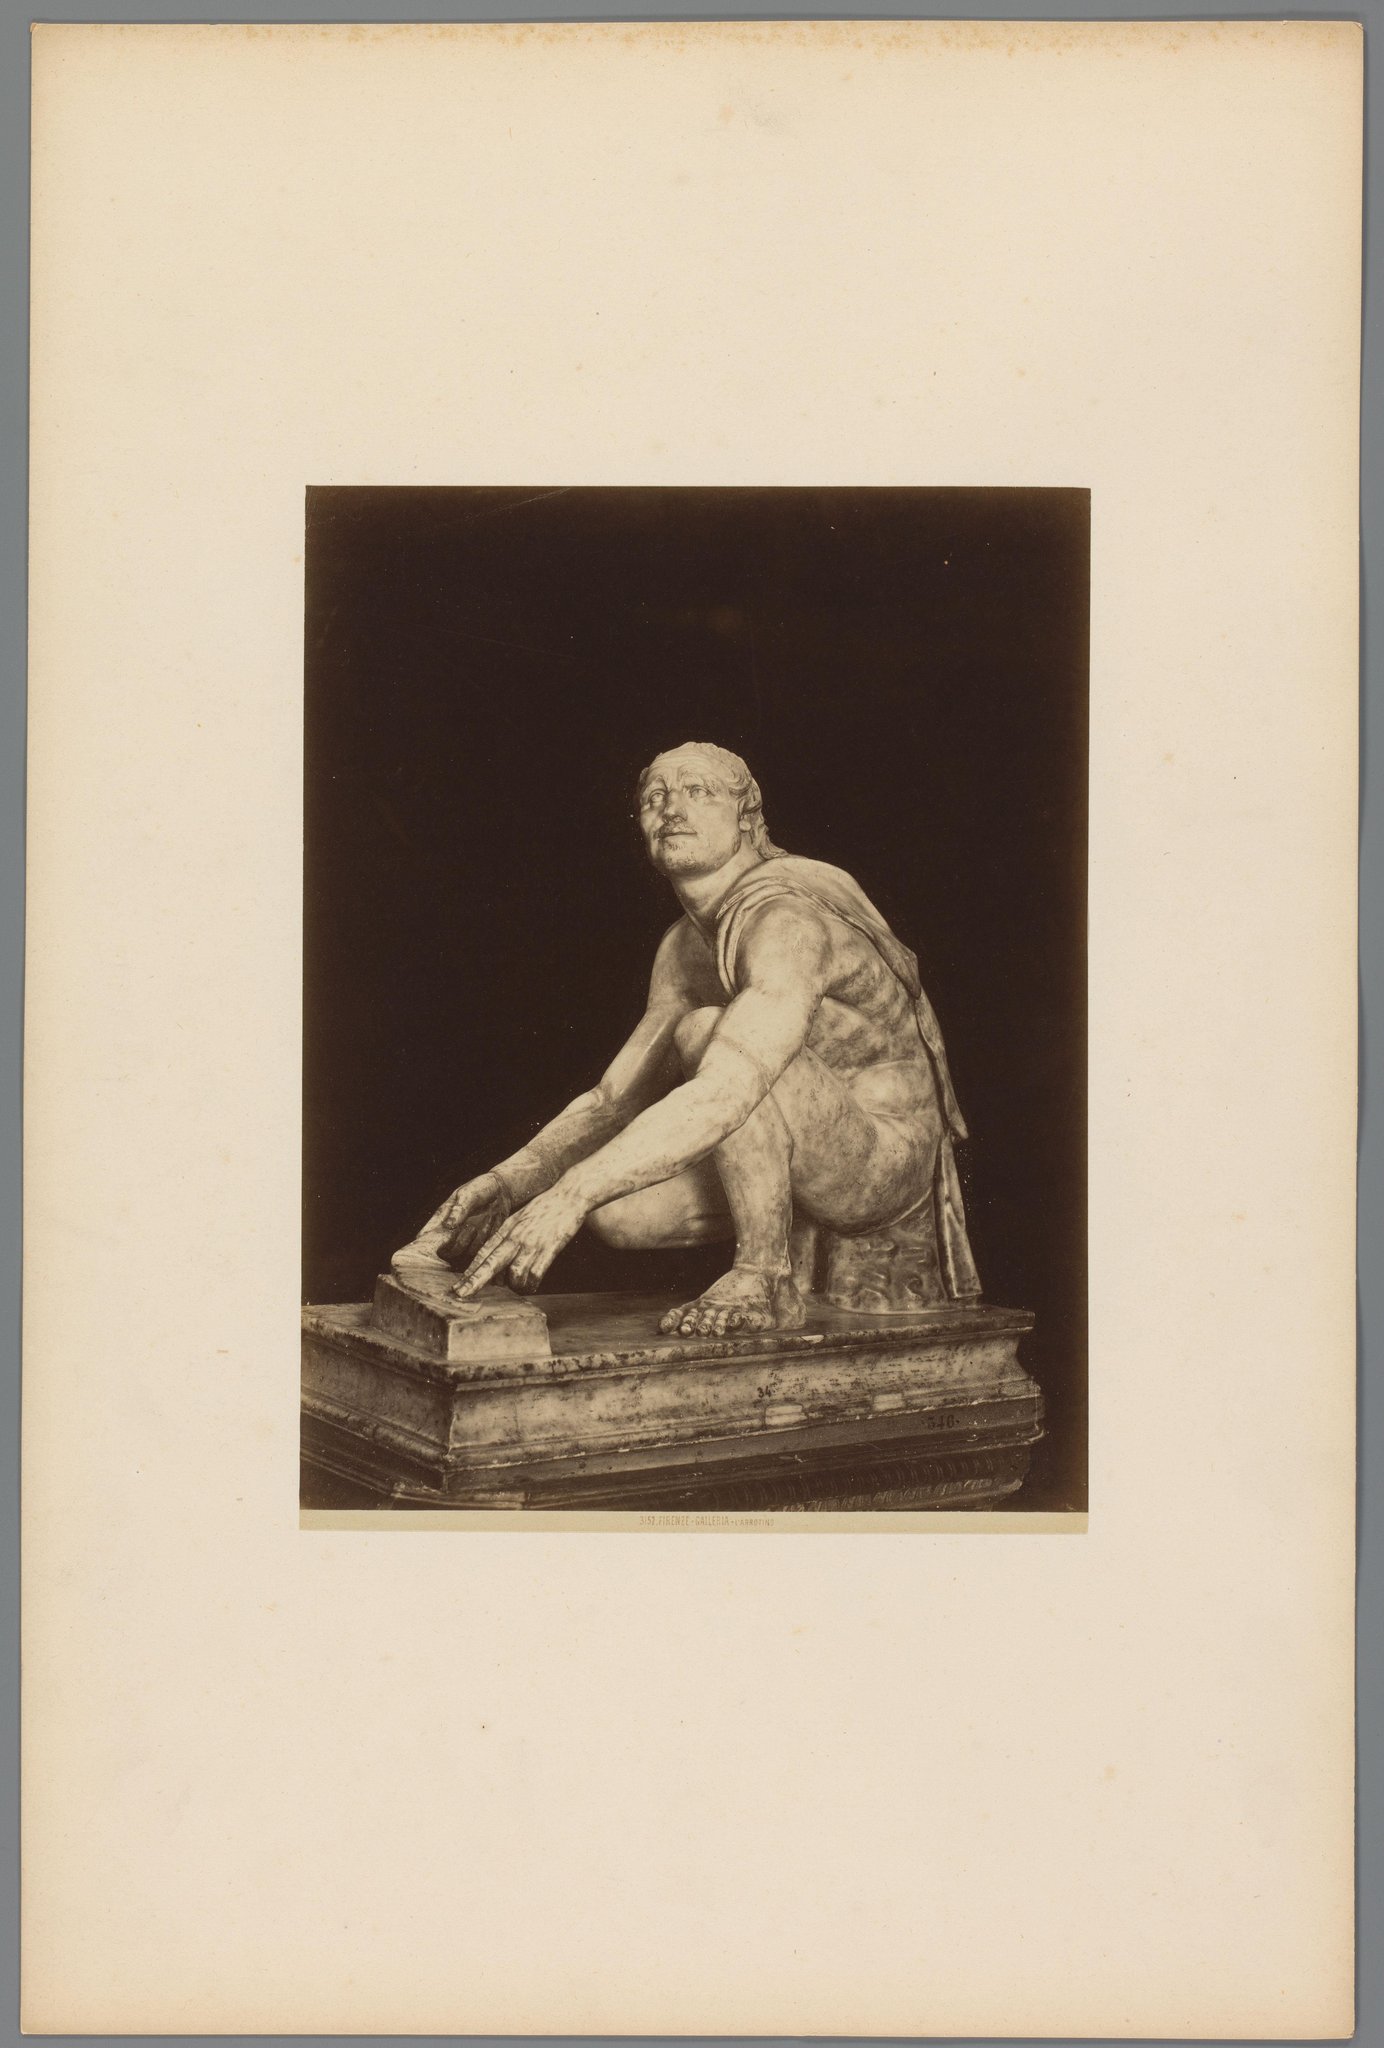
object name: photograph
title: Sculptuur van Arrotino in de Galleria degli Uffizi te Florence, Italië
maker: Anonymous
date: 1851-1900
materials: cardboard, paper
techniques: albumen print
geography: florence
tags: piece of sculpture, reproduction of a piece of sculpture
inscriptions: number: ‘3152.’